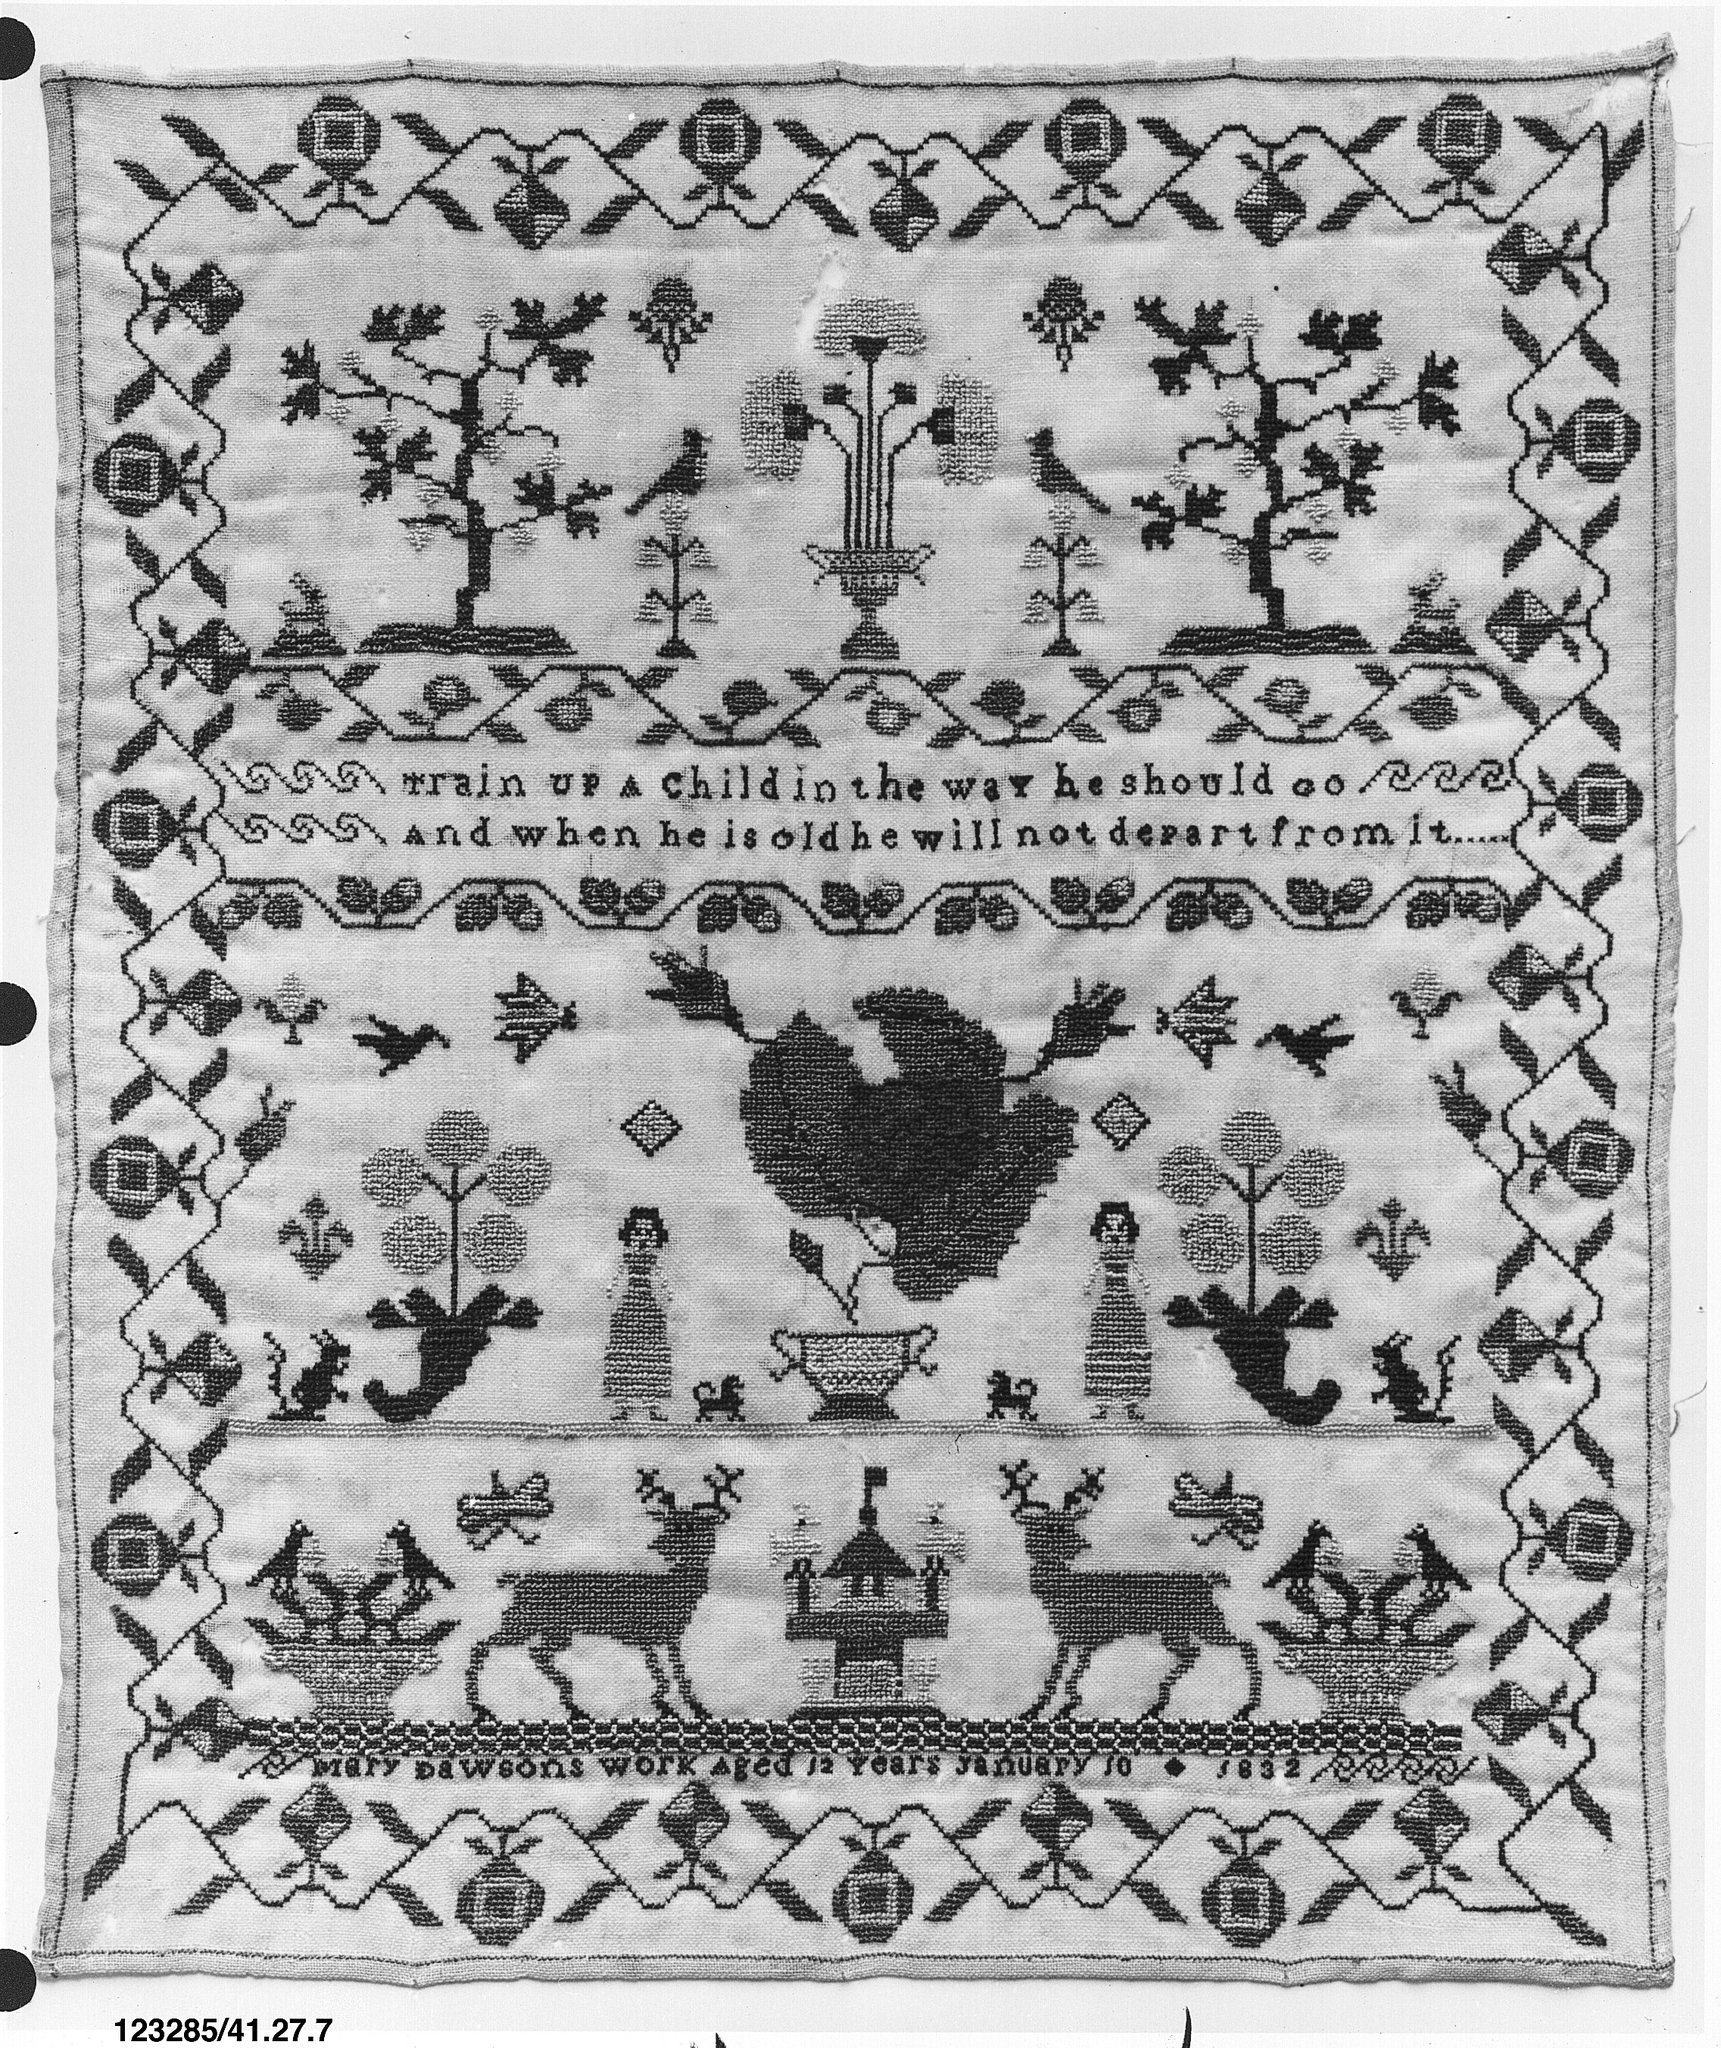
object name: sampler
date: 1832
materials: canvas, silk, wool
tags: human figures,birds,deer